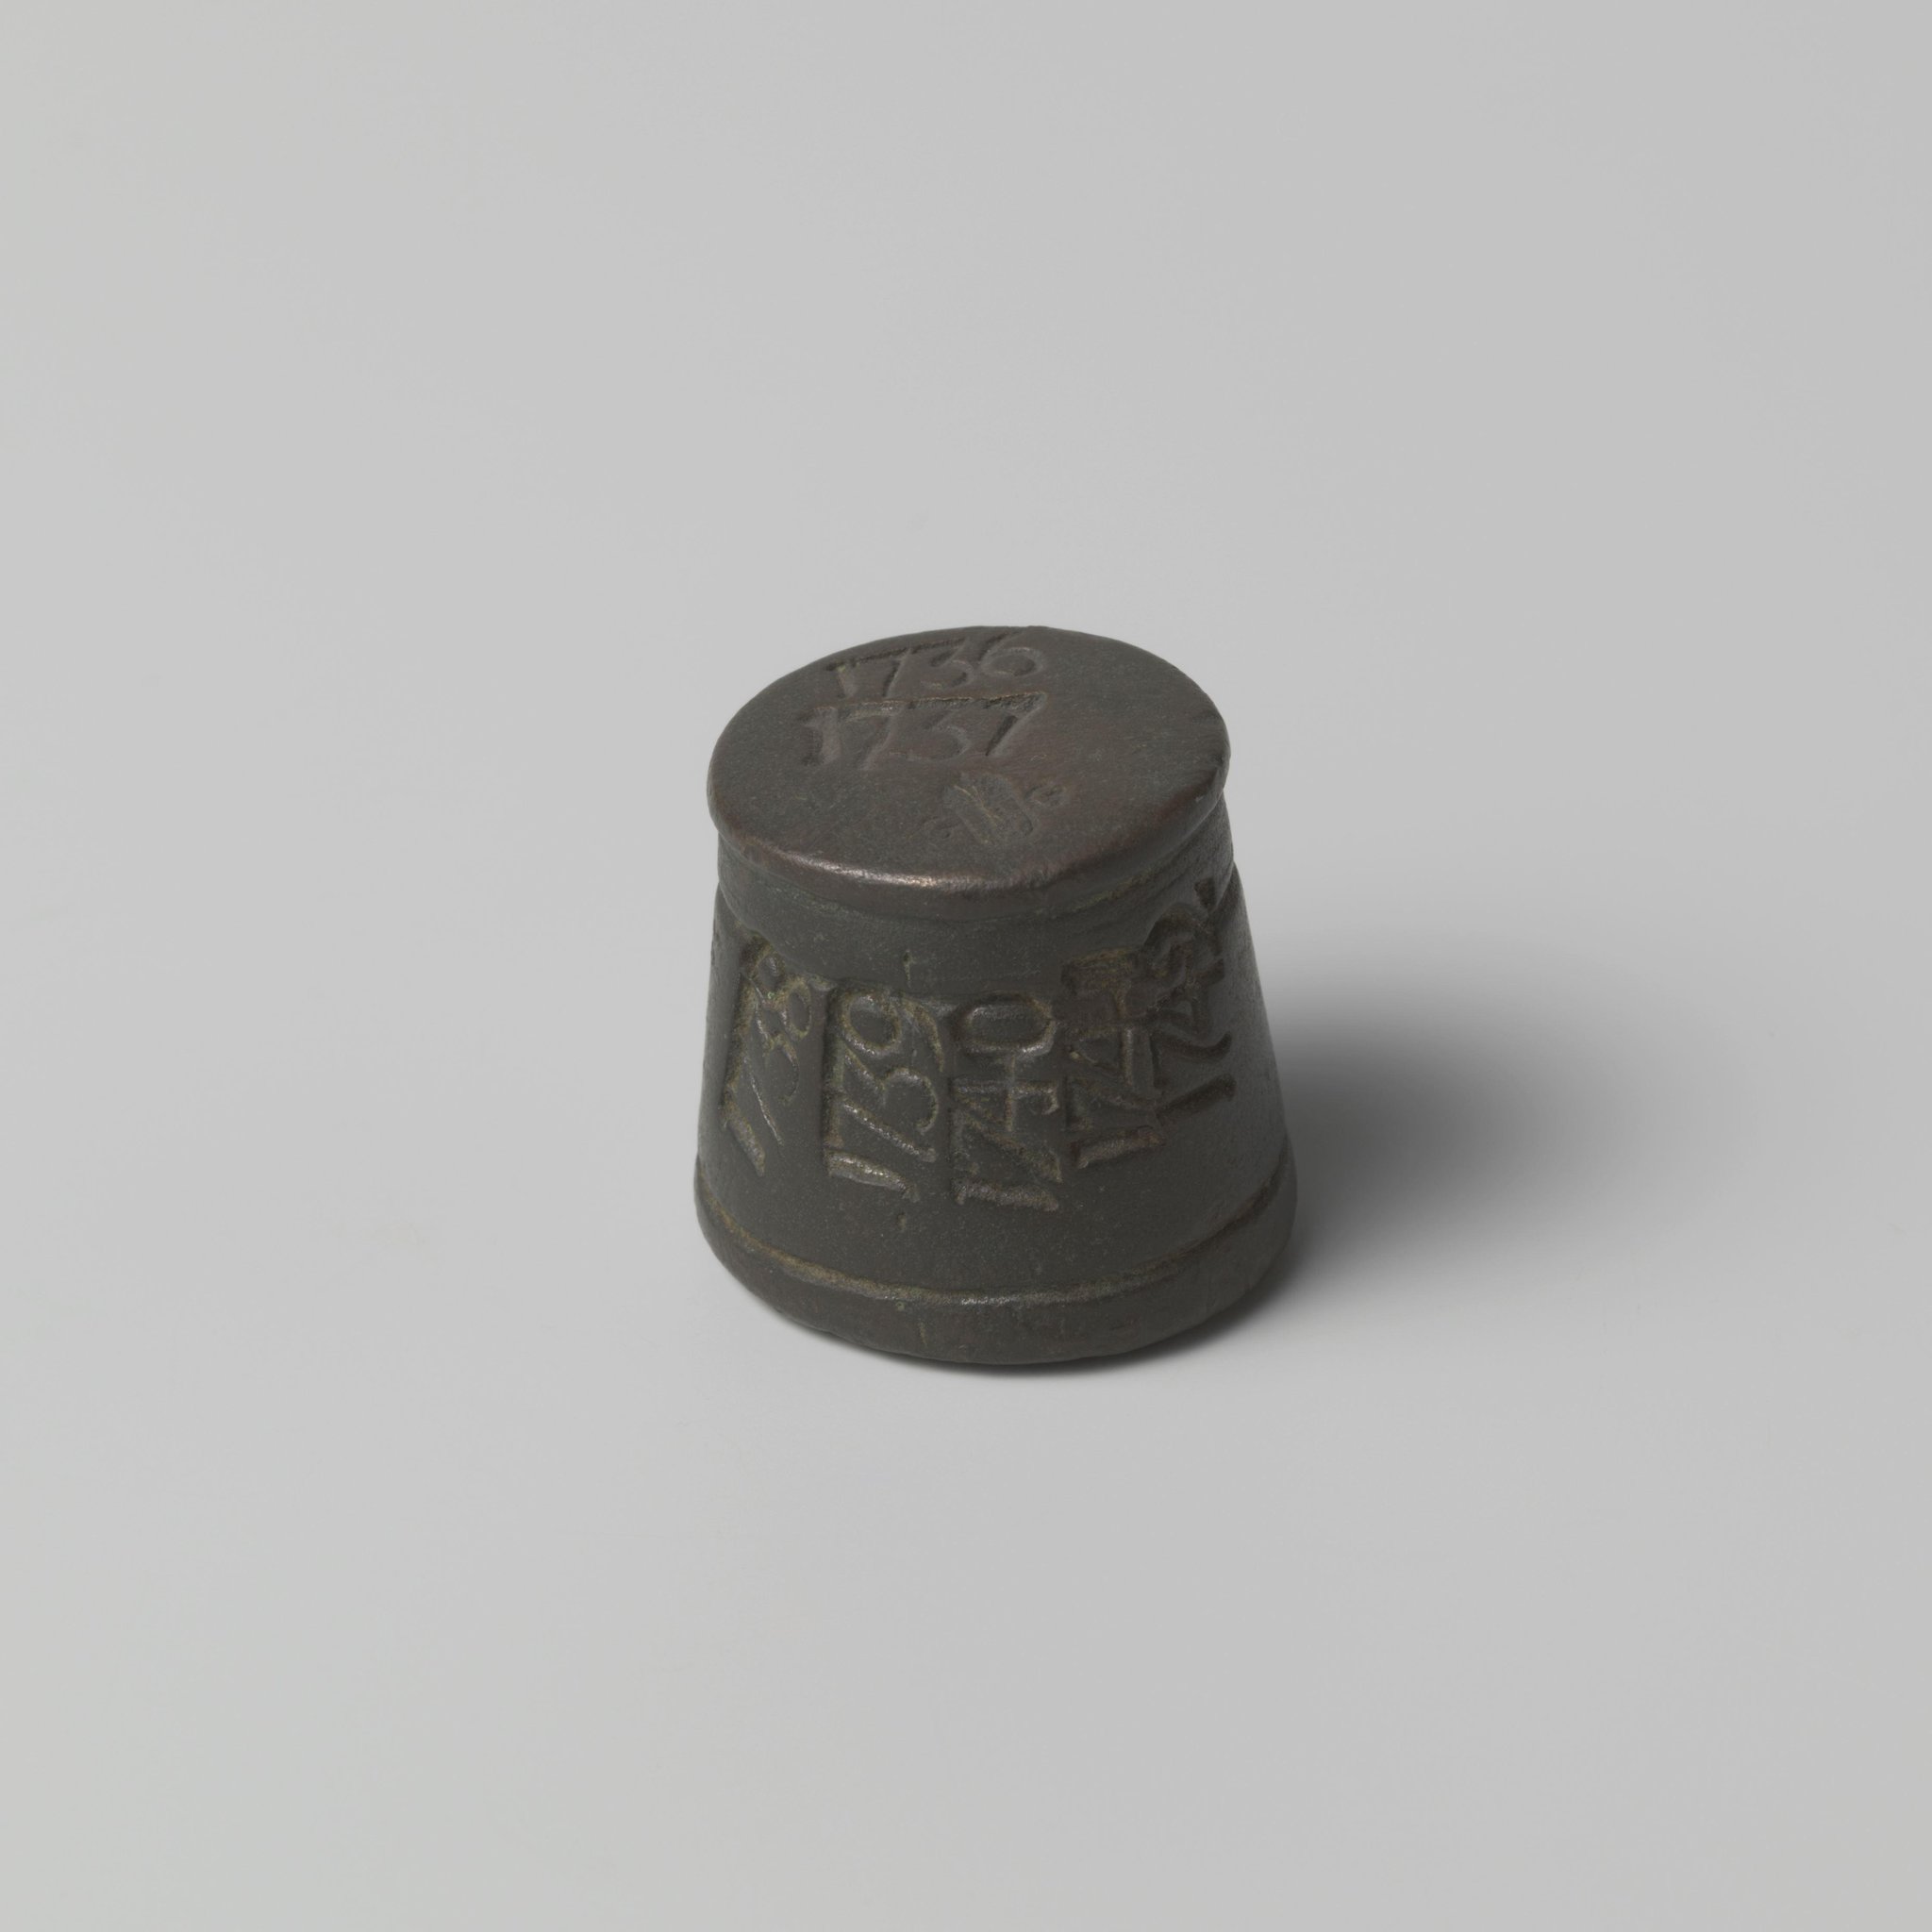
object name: weight scale component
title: Blokgewicht van een half Amsterdams pond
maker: abraham groengraft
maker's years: 1673-1745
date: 1736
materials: brass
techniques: casting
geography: amsterdam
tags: amsterdam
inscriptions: ijkmerk, bovenzijde, afgeslagen: de jaartallen 1736, 1737 en de letters GG naast het Amsterdamse stadswapen., ijkmerk, zijkant, afgeslagen: jaartallen van 1738 t/m 1742.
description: Het gegoten ronde zich naar boven toe versmallende voorwerp heeft een gladde wand, die met twee groeven is versierd, en een platte onder- en bovenkant. In deze laatste, welke iets over de wand uitsteekt, het ingeslagen merk met het gekroonde stadswapen van Amsterdam en GG, alsmede de ingeslagen jaartallen 1736 en 1737. Op de wand de jaartallen 1738 t/m 1742.